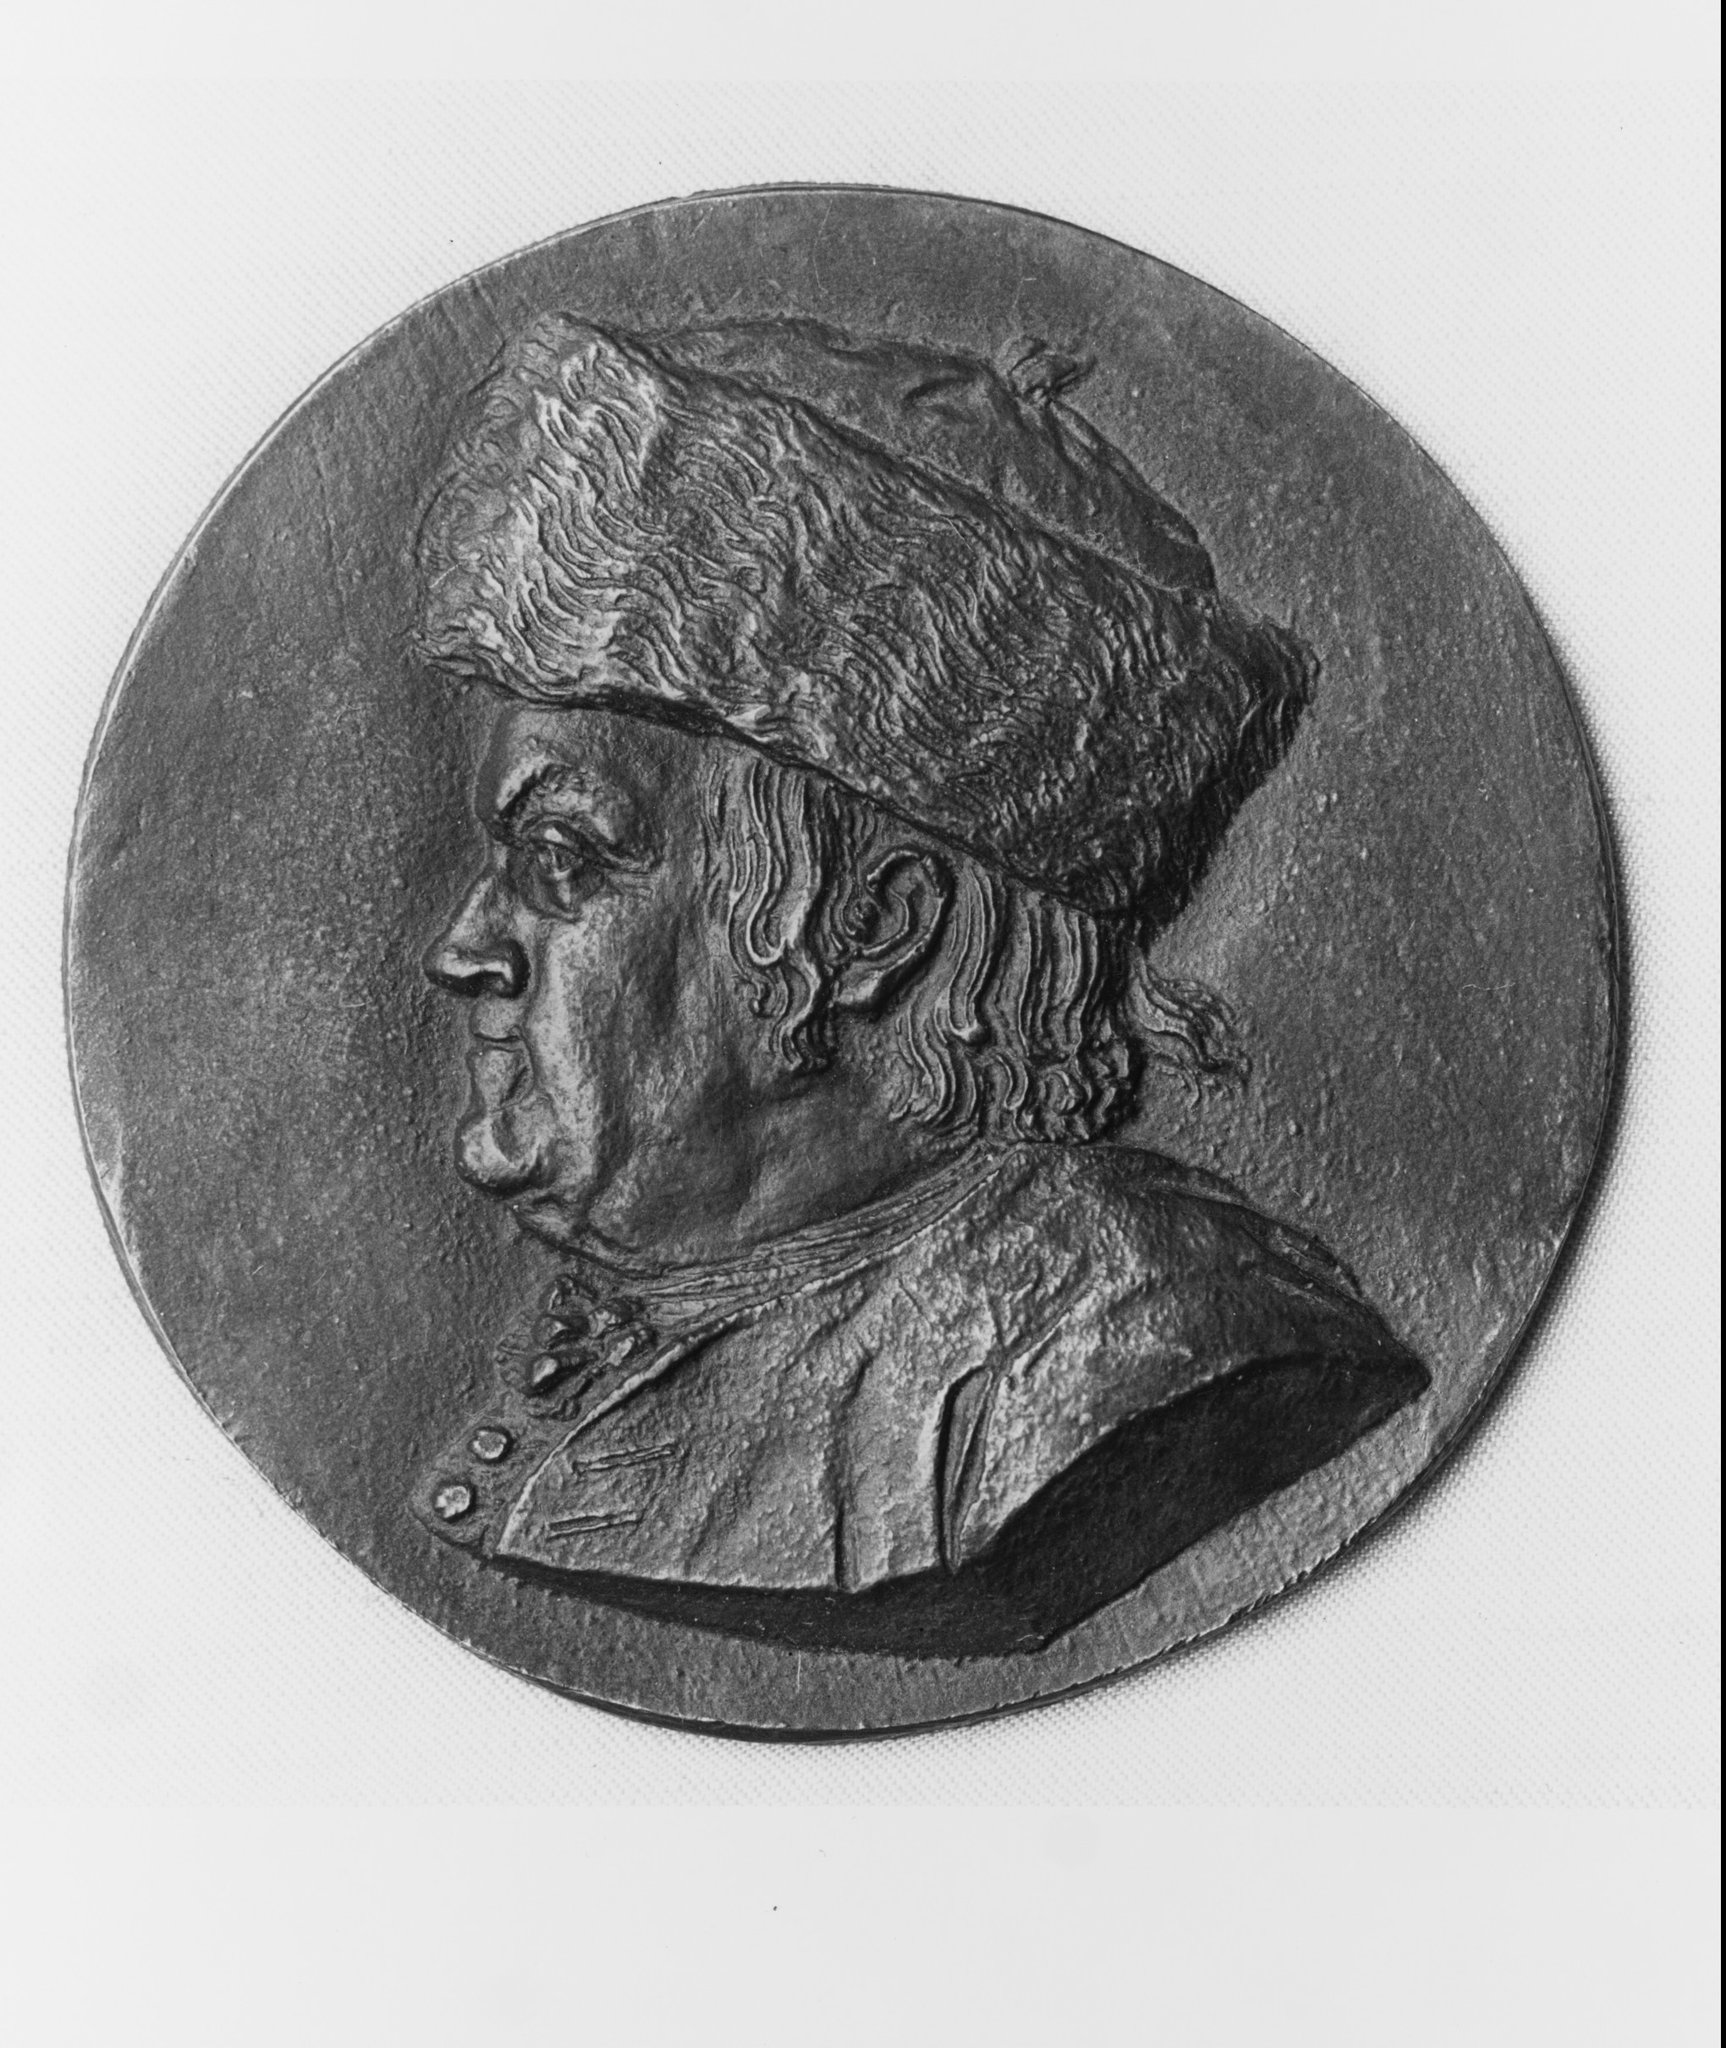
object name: medallion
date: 1776-1883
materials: bronze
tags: men,profiles